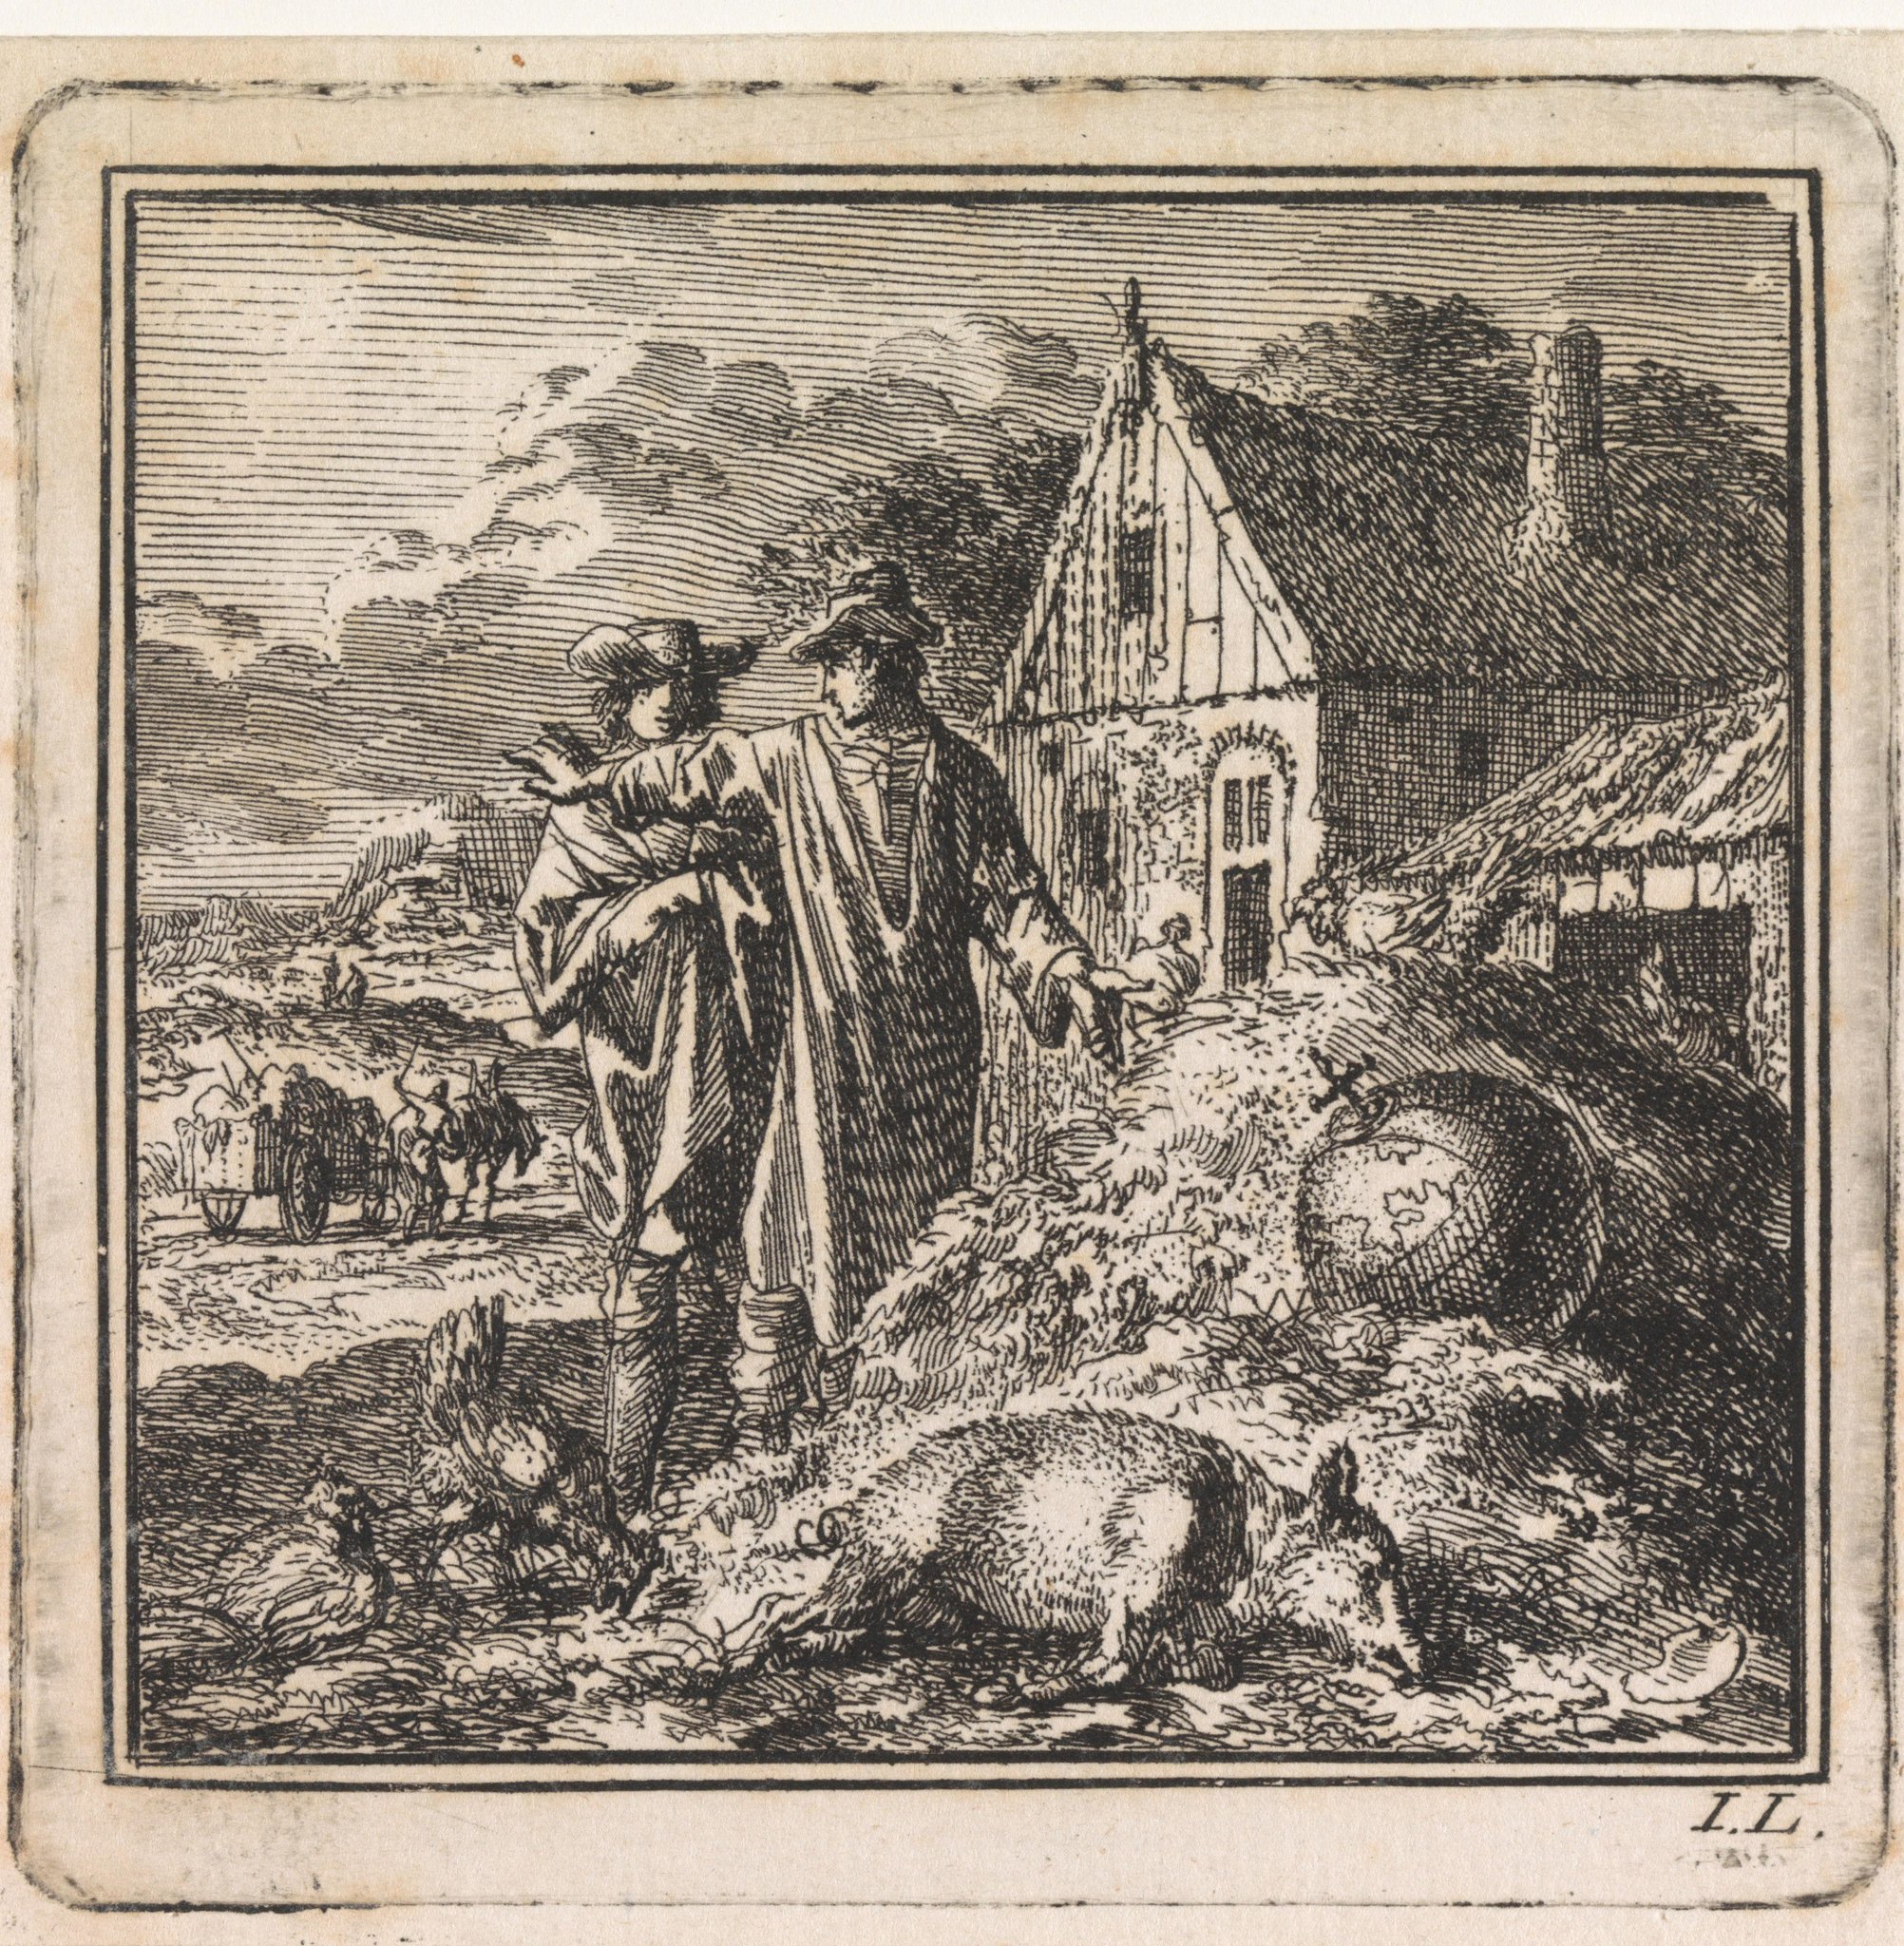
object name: book illustration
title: Het voordeelig weg-ruimen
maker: jan luyken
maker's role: draughtsman, print maker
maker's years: 1649-1712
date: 1710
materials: paper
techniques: etching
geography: amsterdam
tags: earth, world as celestial body, pig, conversation, dialogue; conversation piece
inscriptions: collector's mark: Lugt 2228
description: Illustratie uit: Luyken, Jan. De onwaardige wereld, vertoond in vyftig zinnebeelden, met godlyke spreuken en stichtelyke verzen. Amsterdam: Pieter Arentsz. II (wed.) en Cornelis van der Sys, 1710, p. 160.